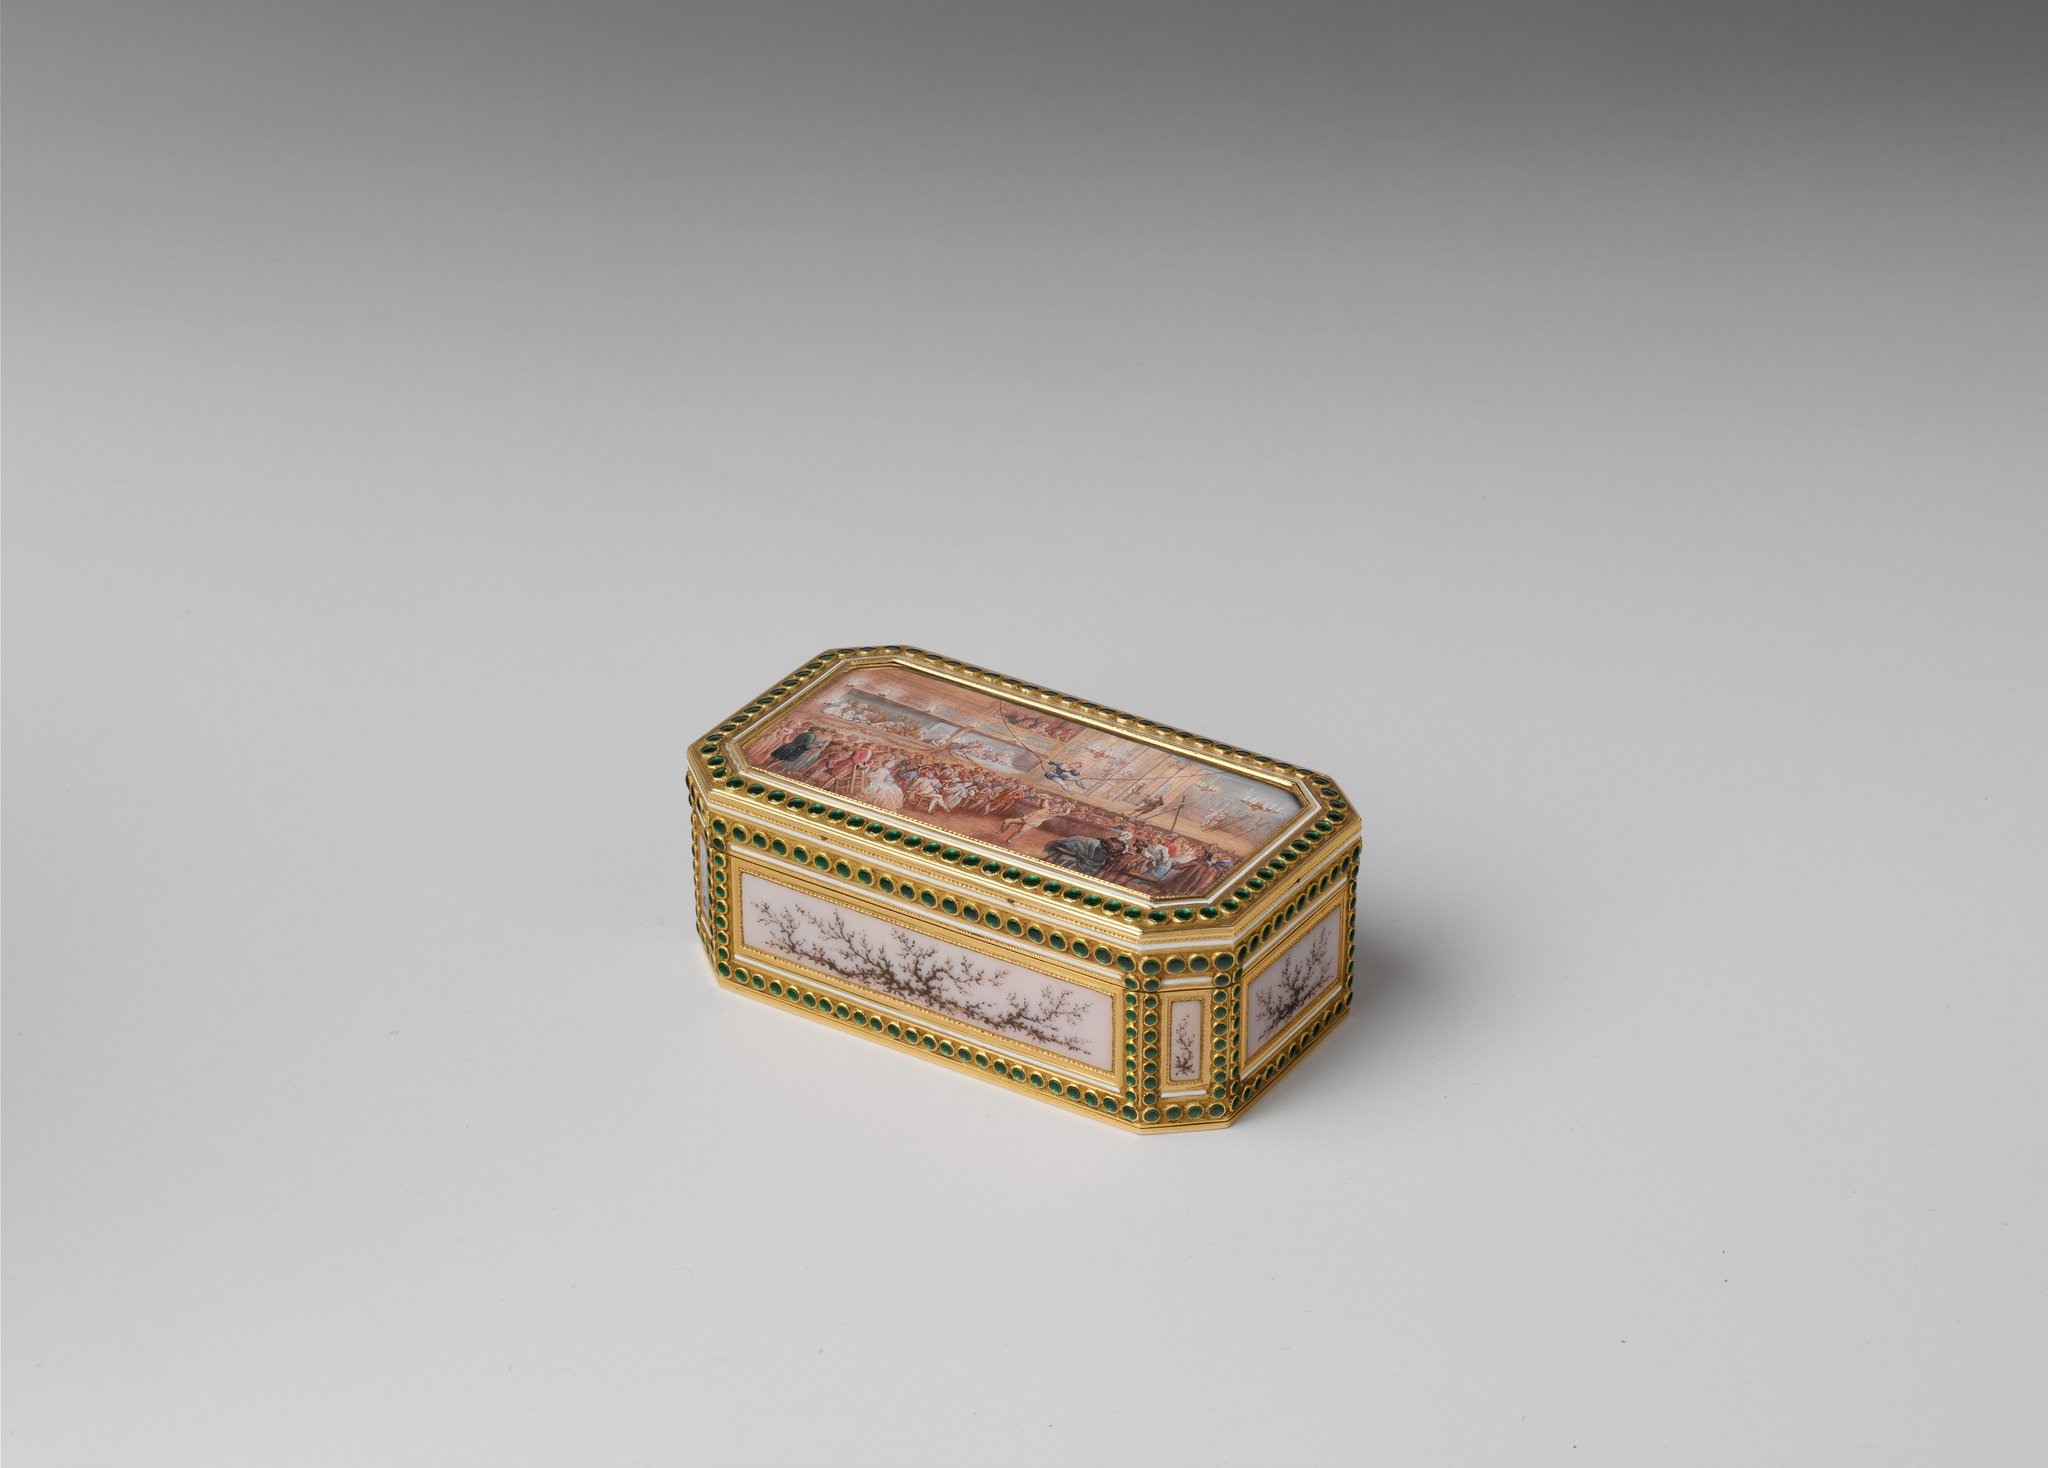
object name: snuffbox, painting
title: Snuffbox with theatrical scenes of a rope dancer and a puppet show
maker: joseph etienne blerzy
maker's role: maker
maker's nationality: french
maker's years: 1750-1806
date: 1778-1779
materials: enamel, gold, parchment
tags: performance,men,women,spectators,dancers,puppets